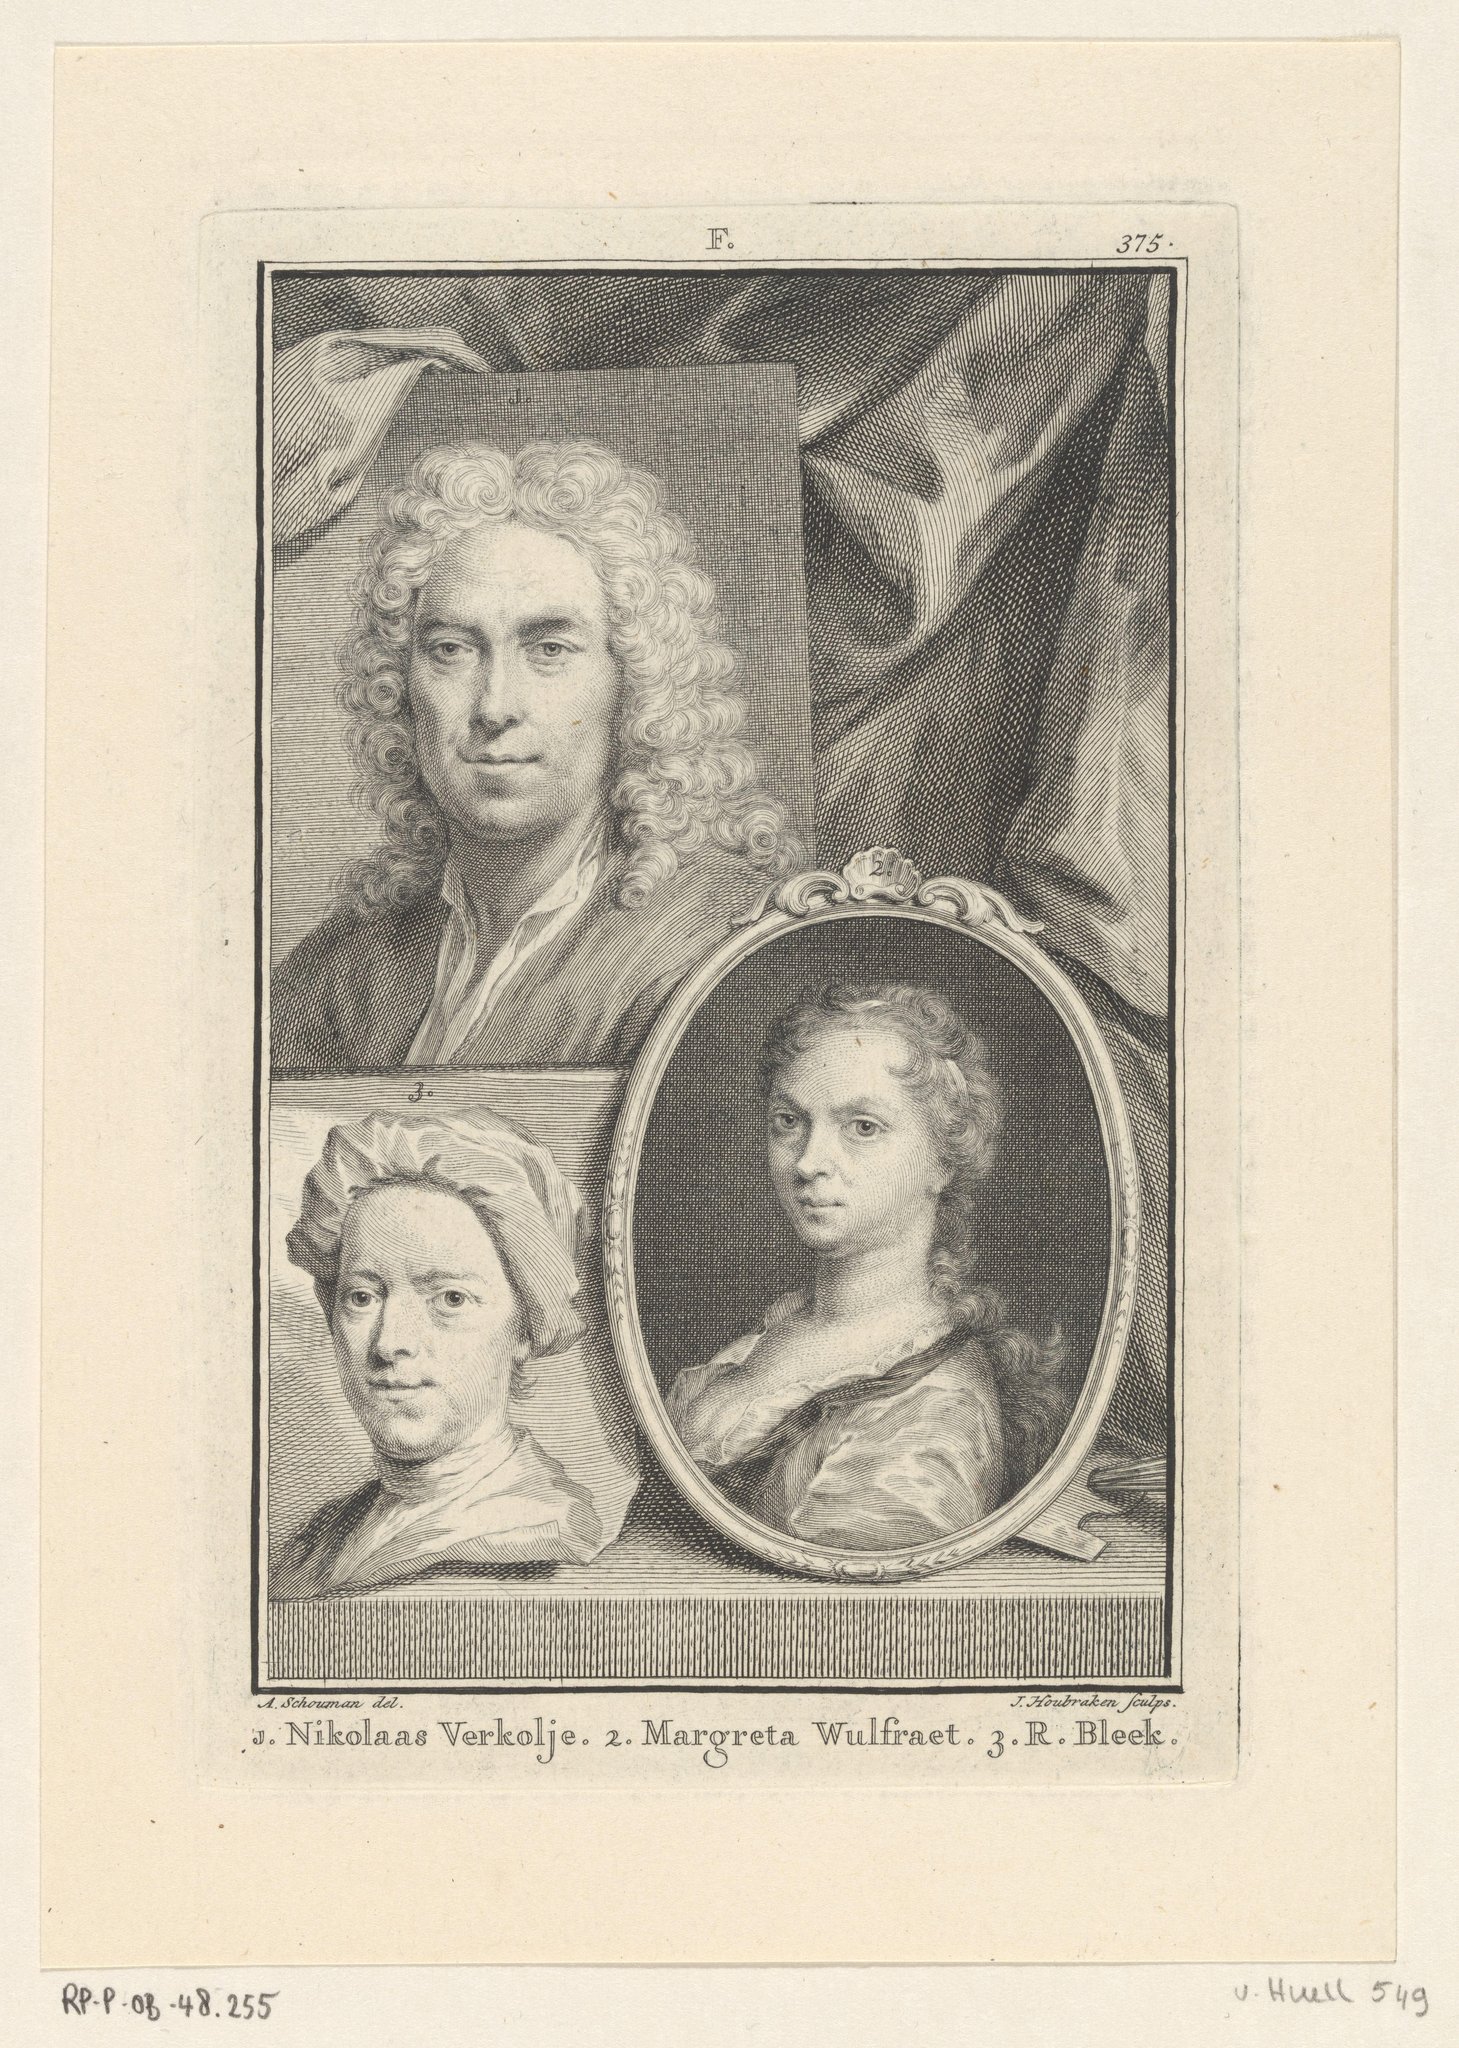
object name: book illustration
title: Portretten van Nicolaas Verkolje, Margareta Wulfraet en Richard van Bleeck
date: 1750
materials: paper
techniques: engraving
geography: amsterdam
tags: the hague, draughtsman, richard van bleeck, delft, nicolaas verkolje, arnhem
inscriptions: collector's mark: Lugt 240, name: ‘JvGool’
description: Prent ook gebruikt in: Johan van Gool. De nieuwe Schouburg der Nederlantsche kunstschilders en schilderessen : waer in de levens- en kunstbedrijven er tans levende en reets overleedene schilders, die van Houbraken, noch eenig ander schrijver, zijn aengeteekend, verhaelt worden. 2 dl. Den Haag: 1750-1751.